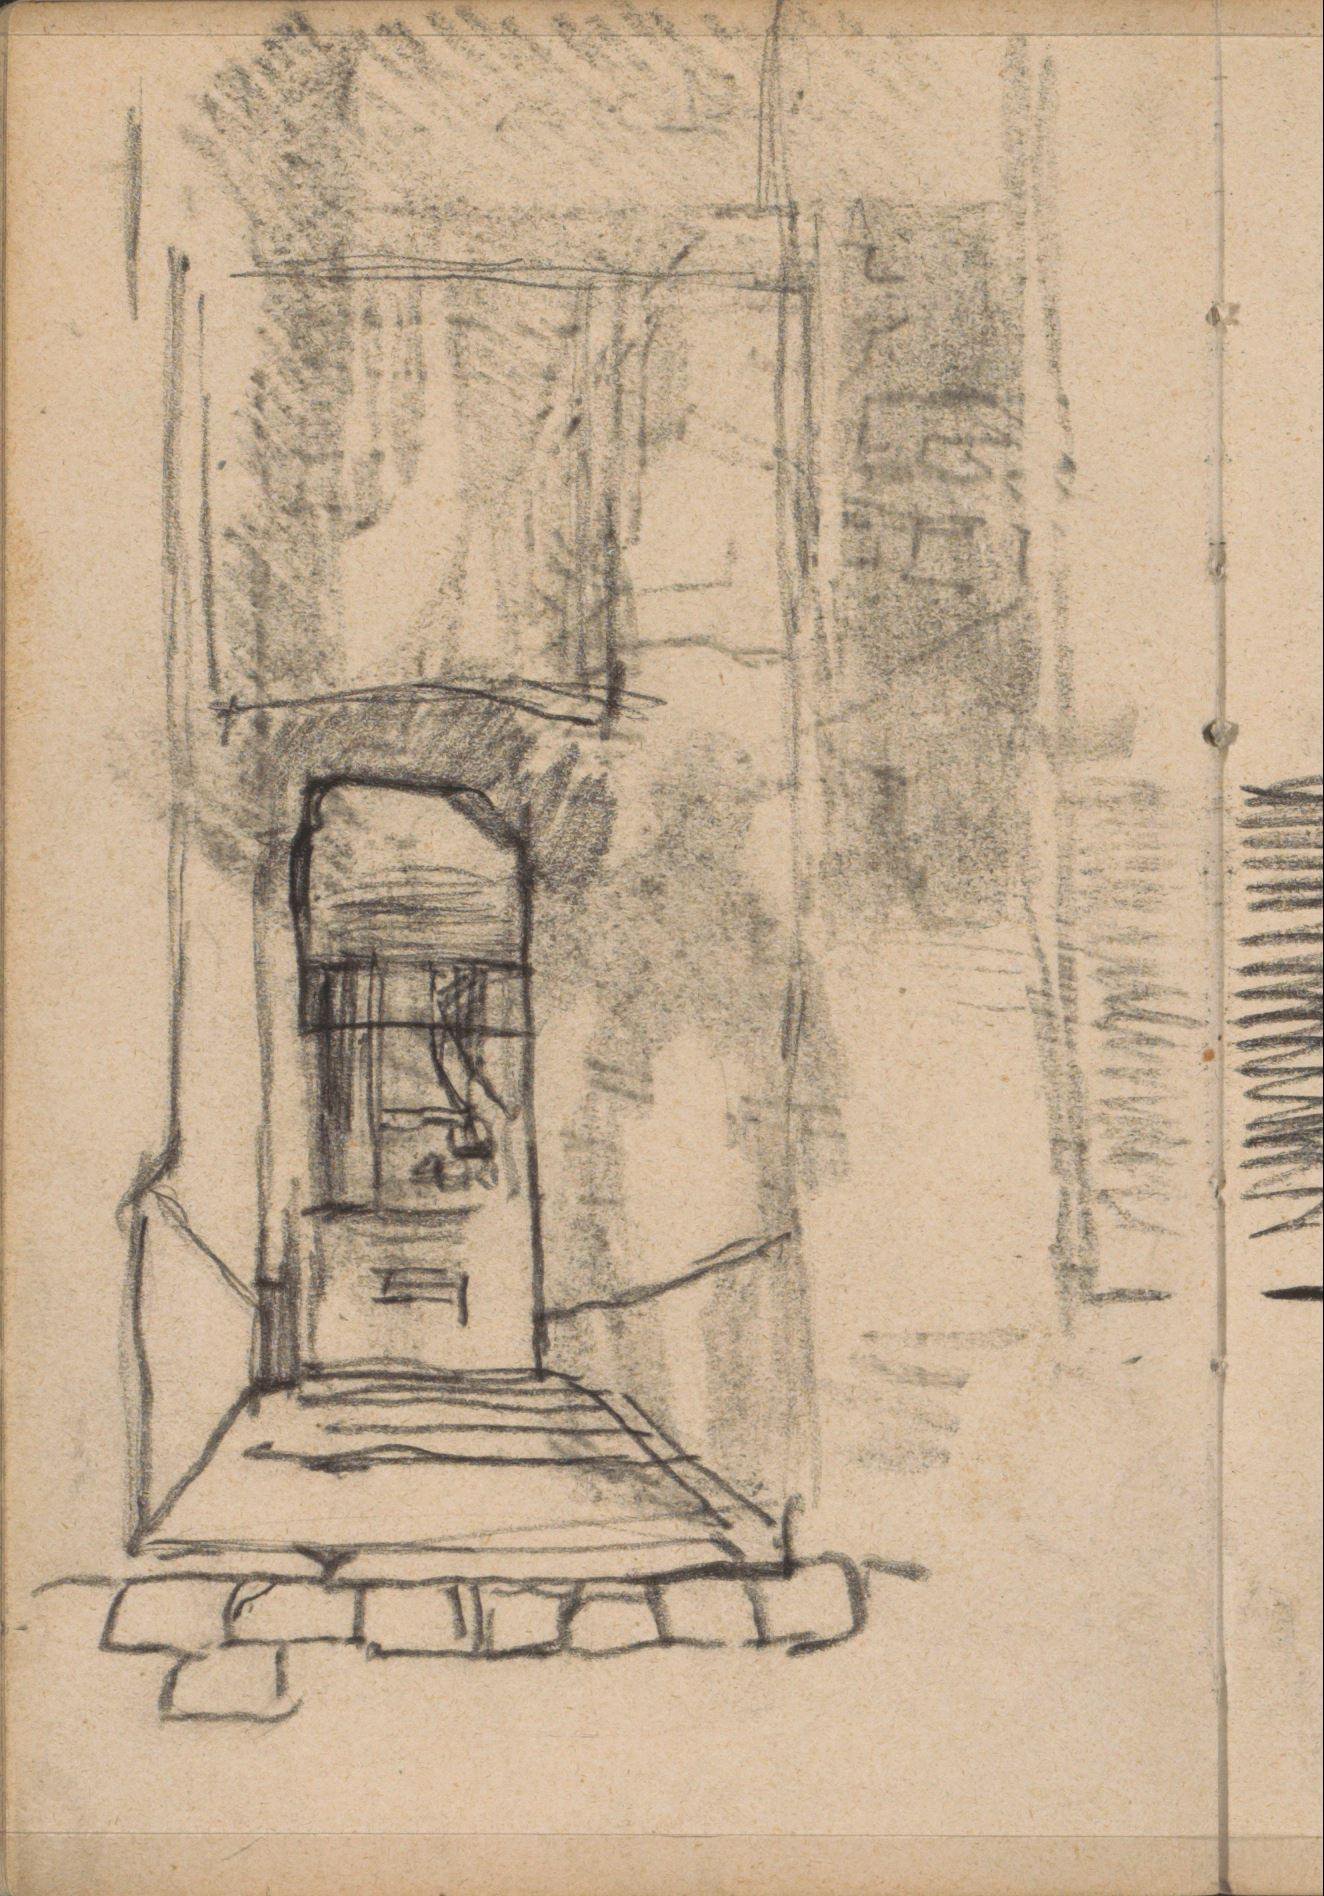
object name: sketchbook leaf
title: Gezicht op een steeg, mogelijk te Gent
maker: george hendrik breitner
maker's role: draughtsman, painter, print maker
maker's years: 1857-1923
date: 1907-1909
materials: chalk, paper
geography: ghent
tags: urban housing, lane, alley, ghent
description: Gezicht op een steeg, mogelijk te Gent. Pagina 13 uit een schetsboek met 46 bladen vervaardigd te Antwerpen, Gent en Amsterdam.